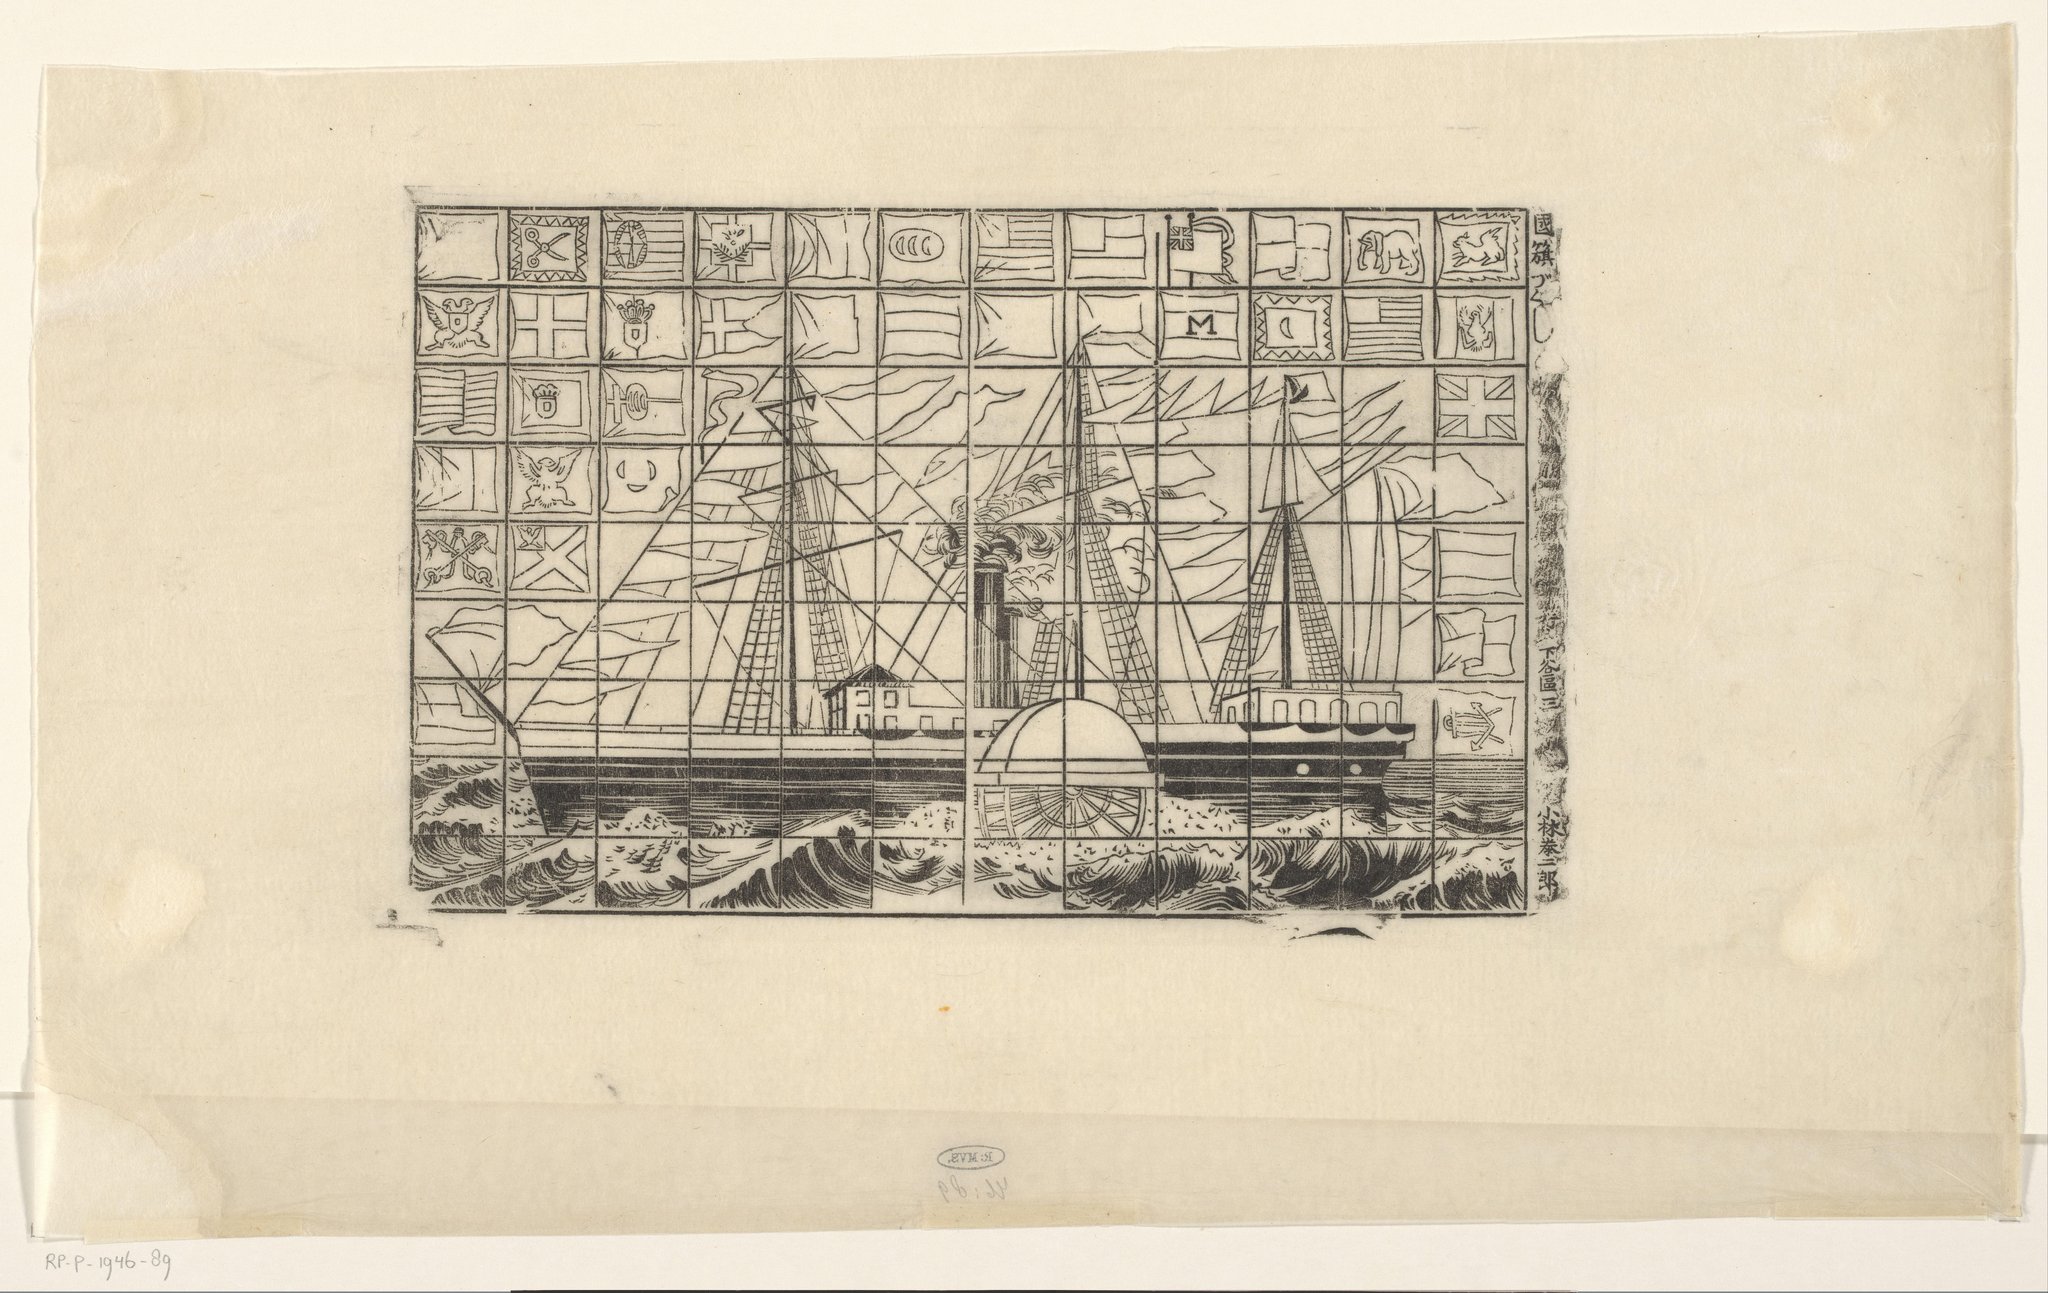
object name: print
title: Raderboot (bovenste blad)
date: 1883-1942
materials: paper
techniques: woodcut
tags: flag, colours (as symbol of the state, etc.), paddle-wheel boat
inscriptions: collector's mark: Lugt 2228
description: Raderboot met vlaggen achter een raster. Bovenaan zijn de vlakken van het raster gevuld met vlaggen van verschillende landen. Rechts Japanse karakters.